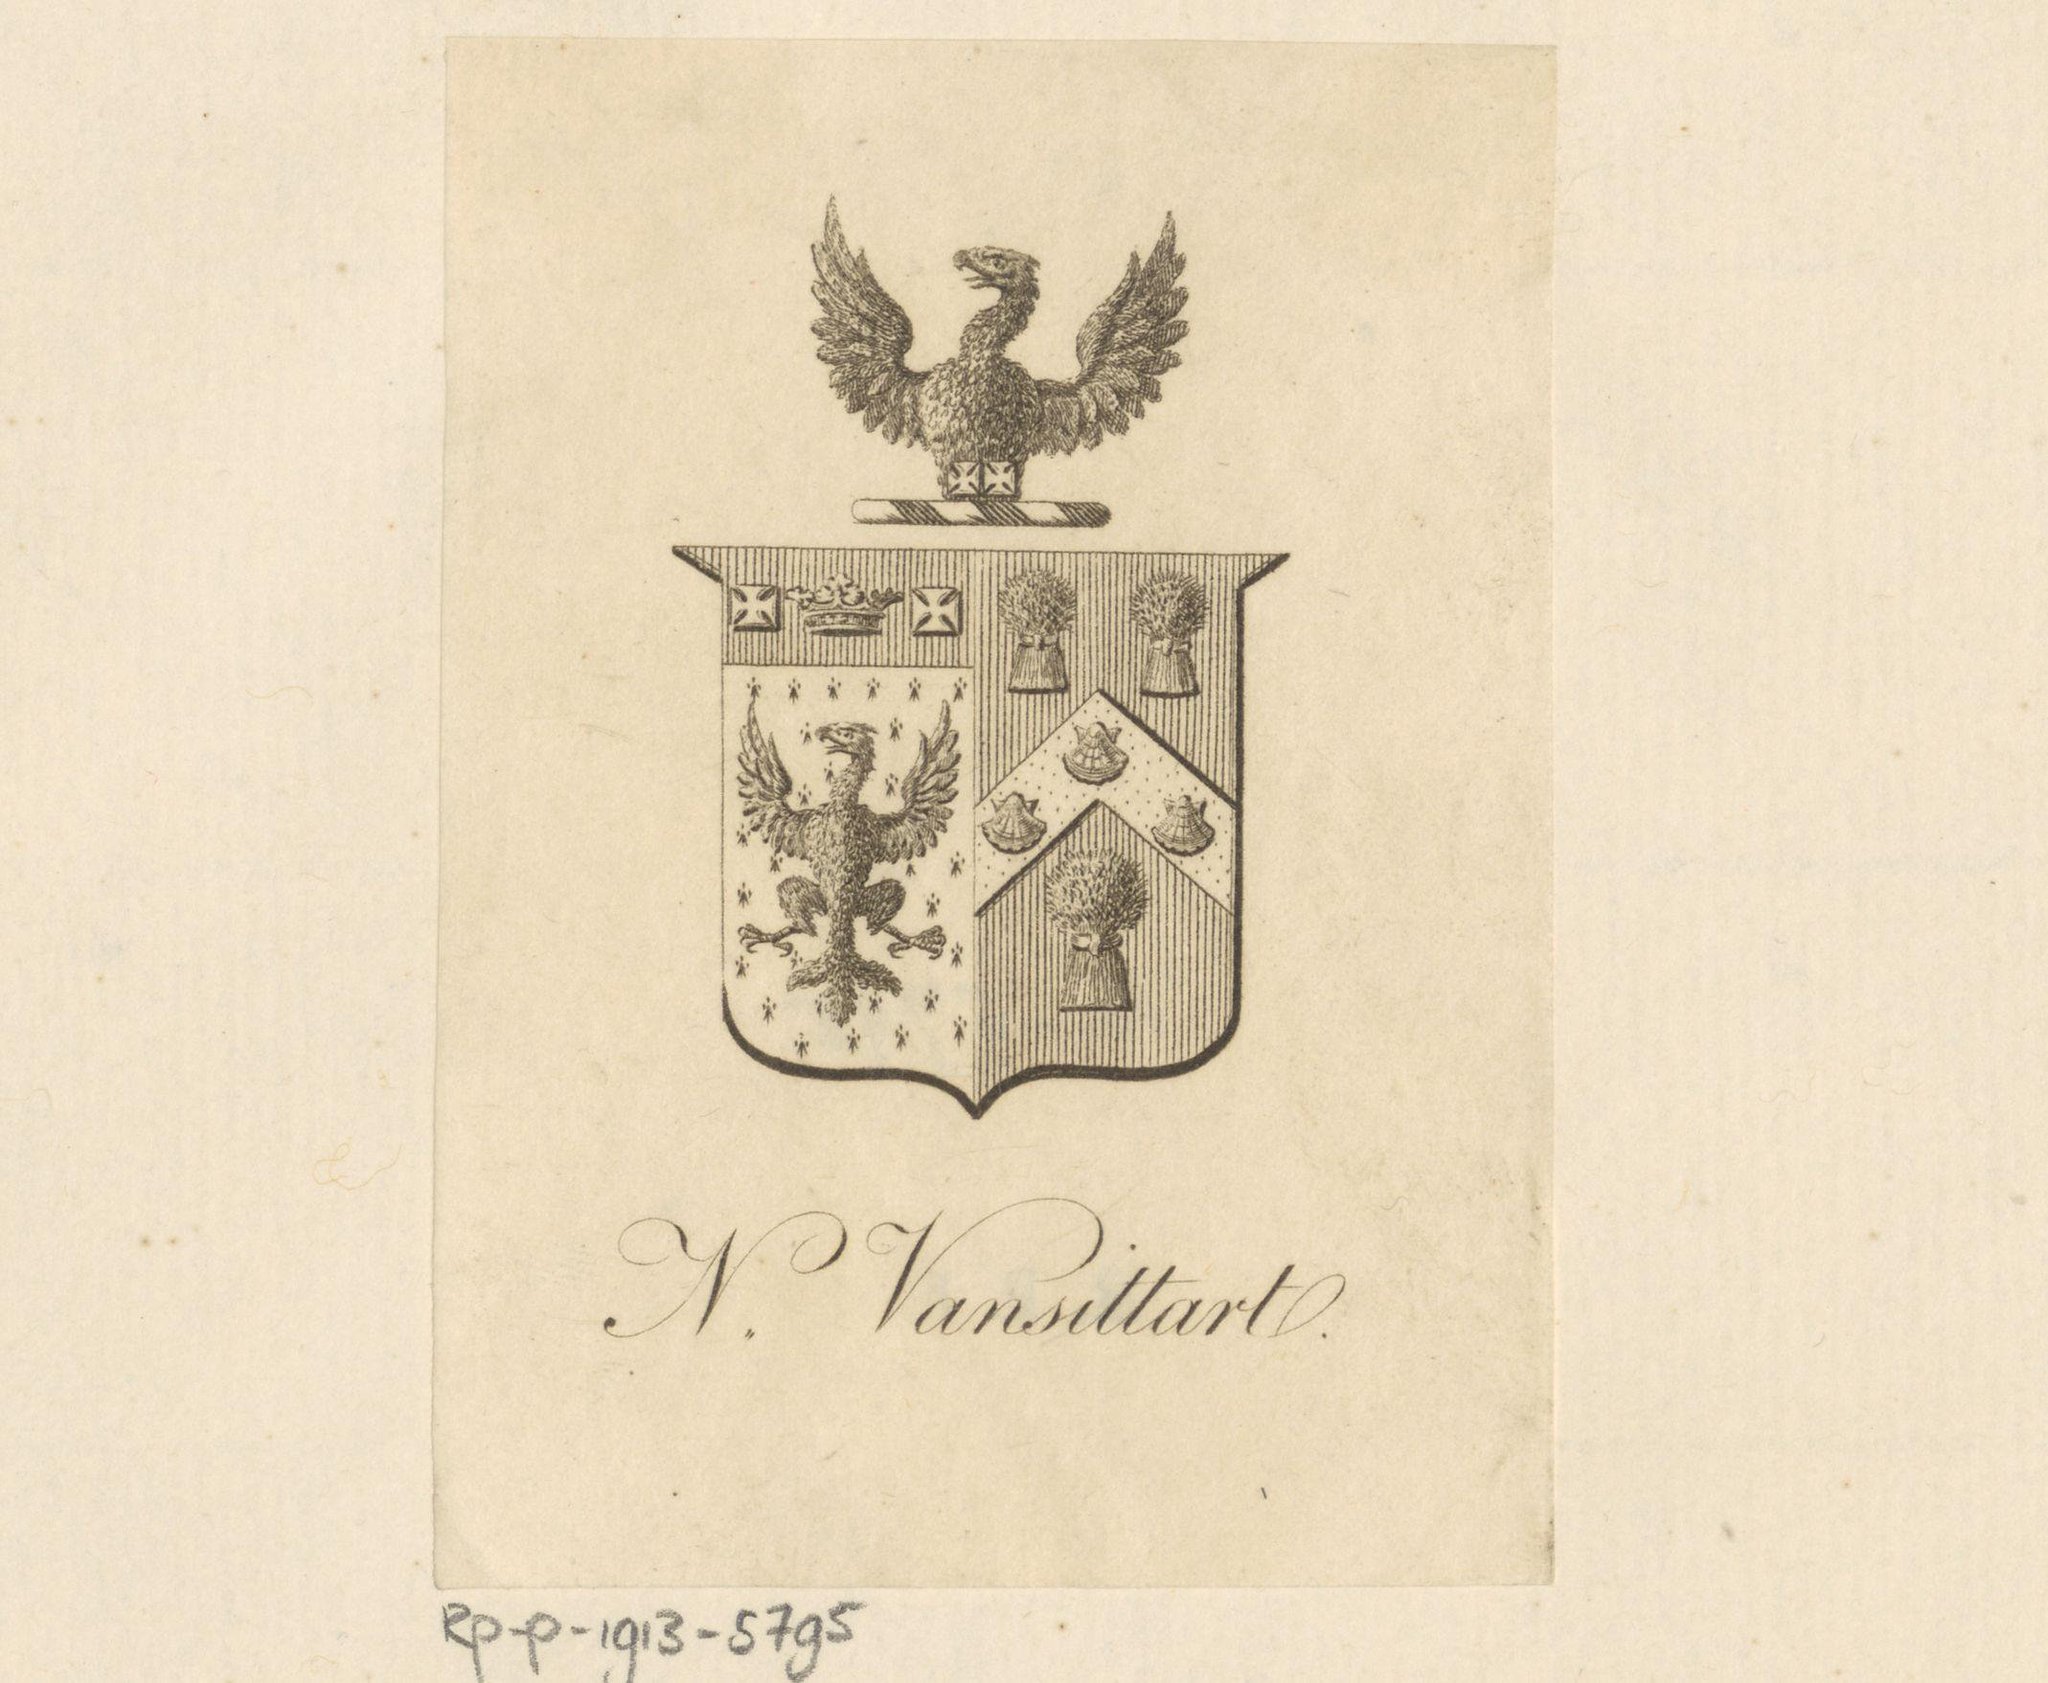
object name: bookplate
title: Ex libris van N. Vansittart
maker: Anonymous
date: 1800-1899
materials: paper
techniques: etching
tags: armorial bearing, heraldry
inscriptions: collector's mark: Lugt 2760, collector's mark: Lugt 2233